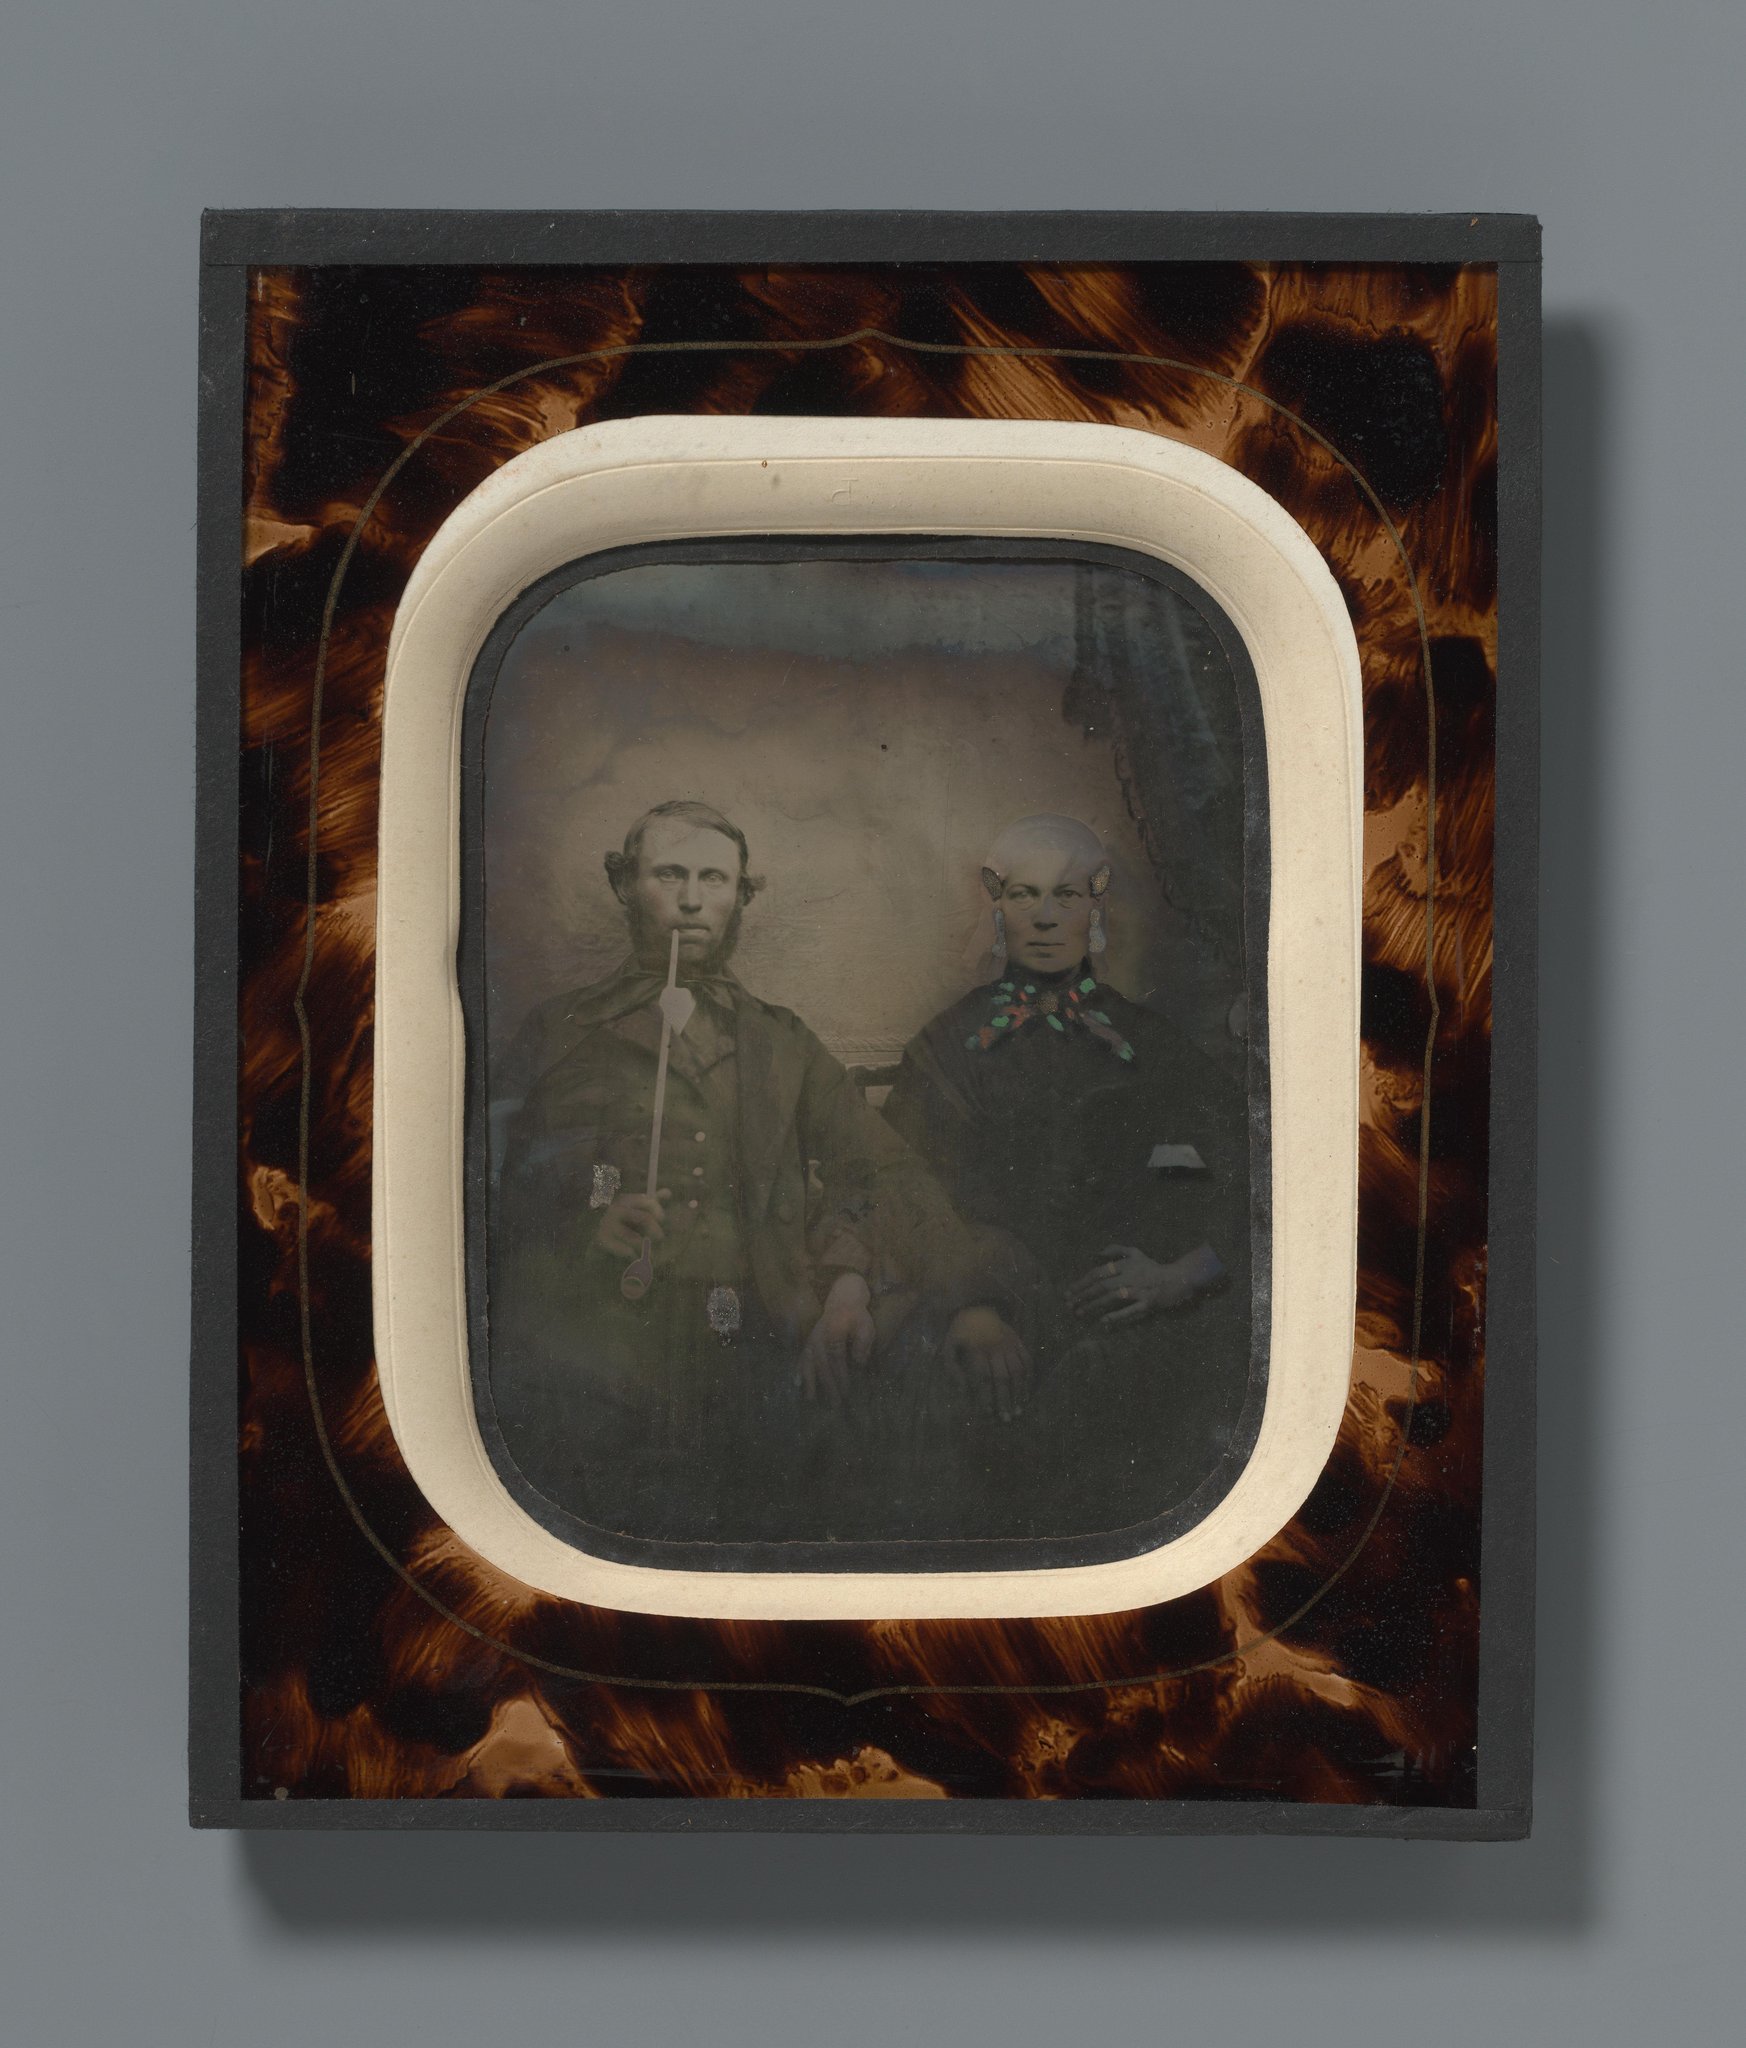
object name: photograph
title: Portret van een onbekend Fries echtpaar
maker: Anonymous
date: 1855-1870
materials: glass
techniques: ambrotype, hand coloring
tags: historical persons - bb - woman, historical persons, marriage, married couple, 'matrimonium', folk costume, regional costume